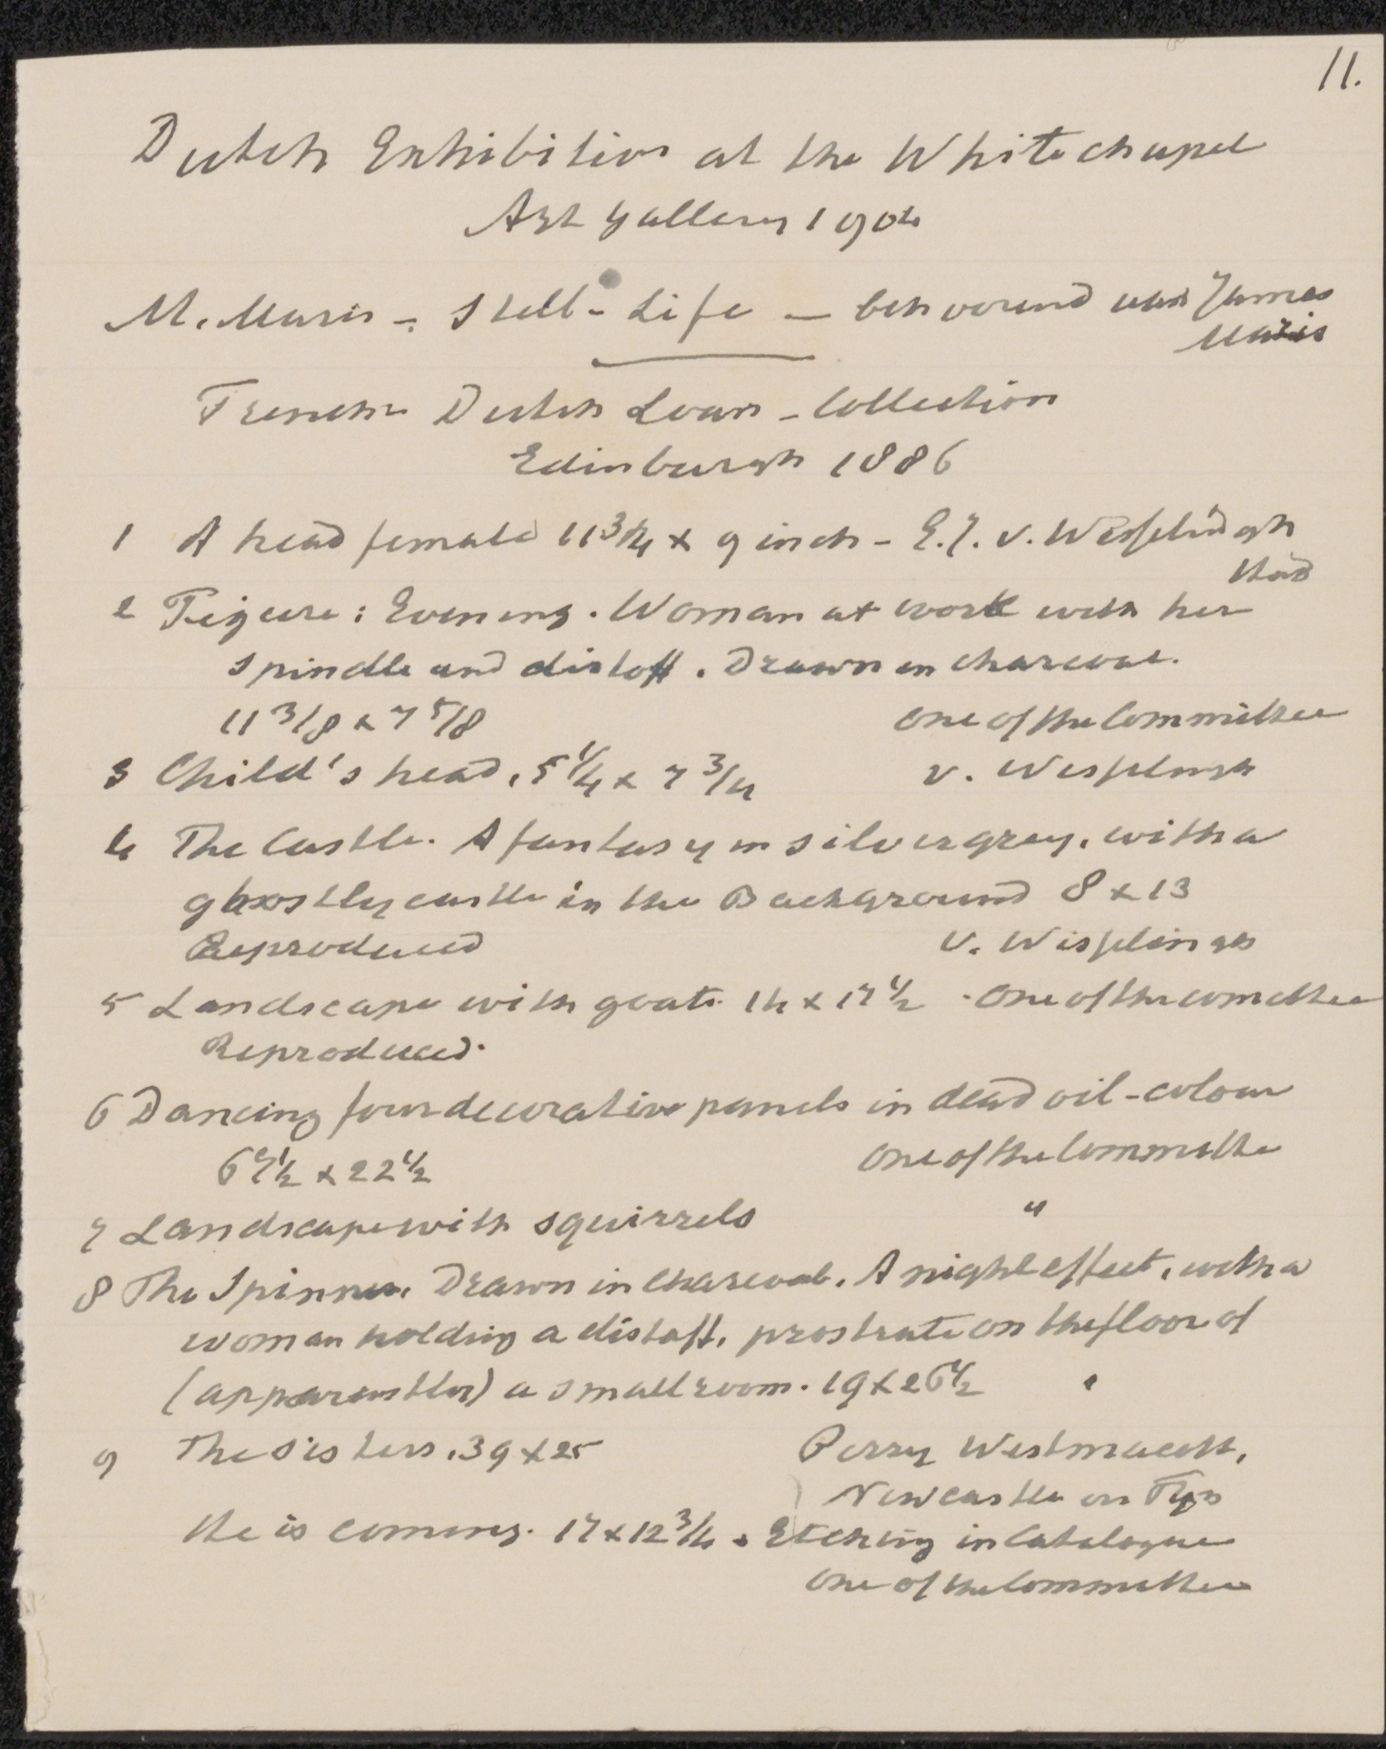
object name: aantekening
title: Aantekening betreffende Matthijs Maris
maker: pieter haverkorn van rijsewijk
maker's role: museumdirecteur, publicist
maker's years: 1839-1919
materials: ink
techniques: pen, writing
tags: the hague, london, painter, print maker, draughtsman, matthijs maris, drawing, the graphic arts, painting (including book-illumination, miniature-painting), exhibition ~ art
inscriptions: watermark